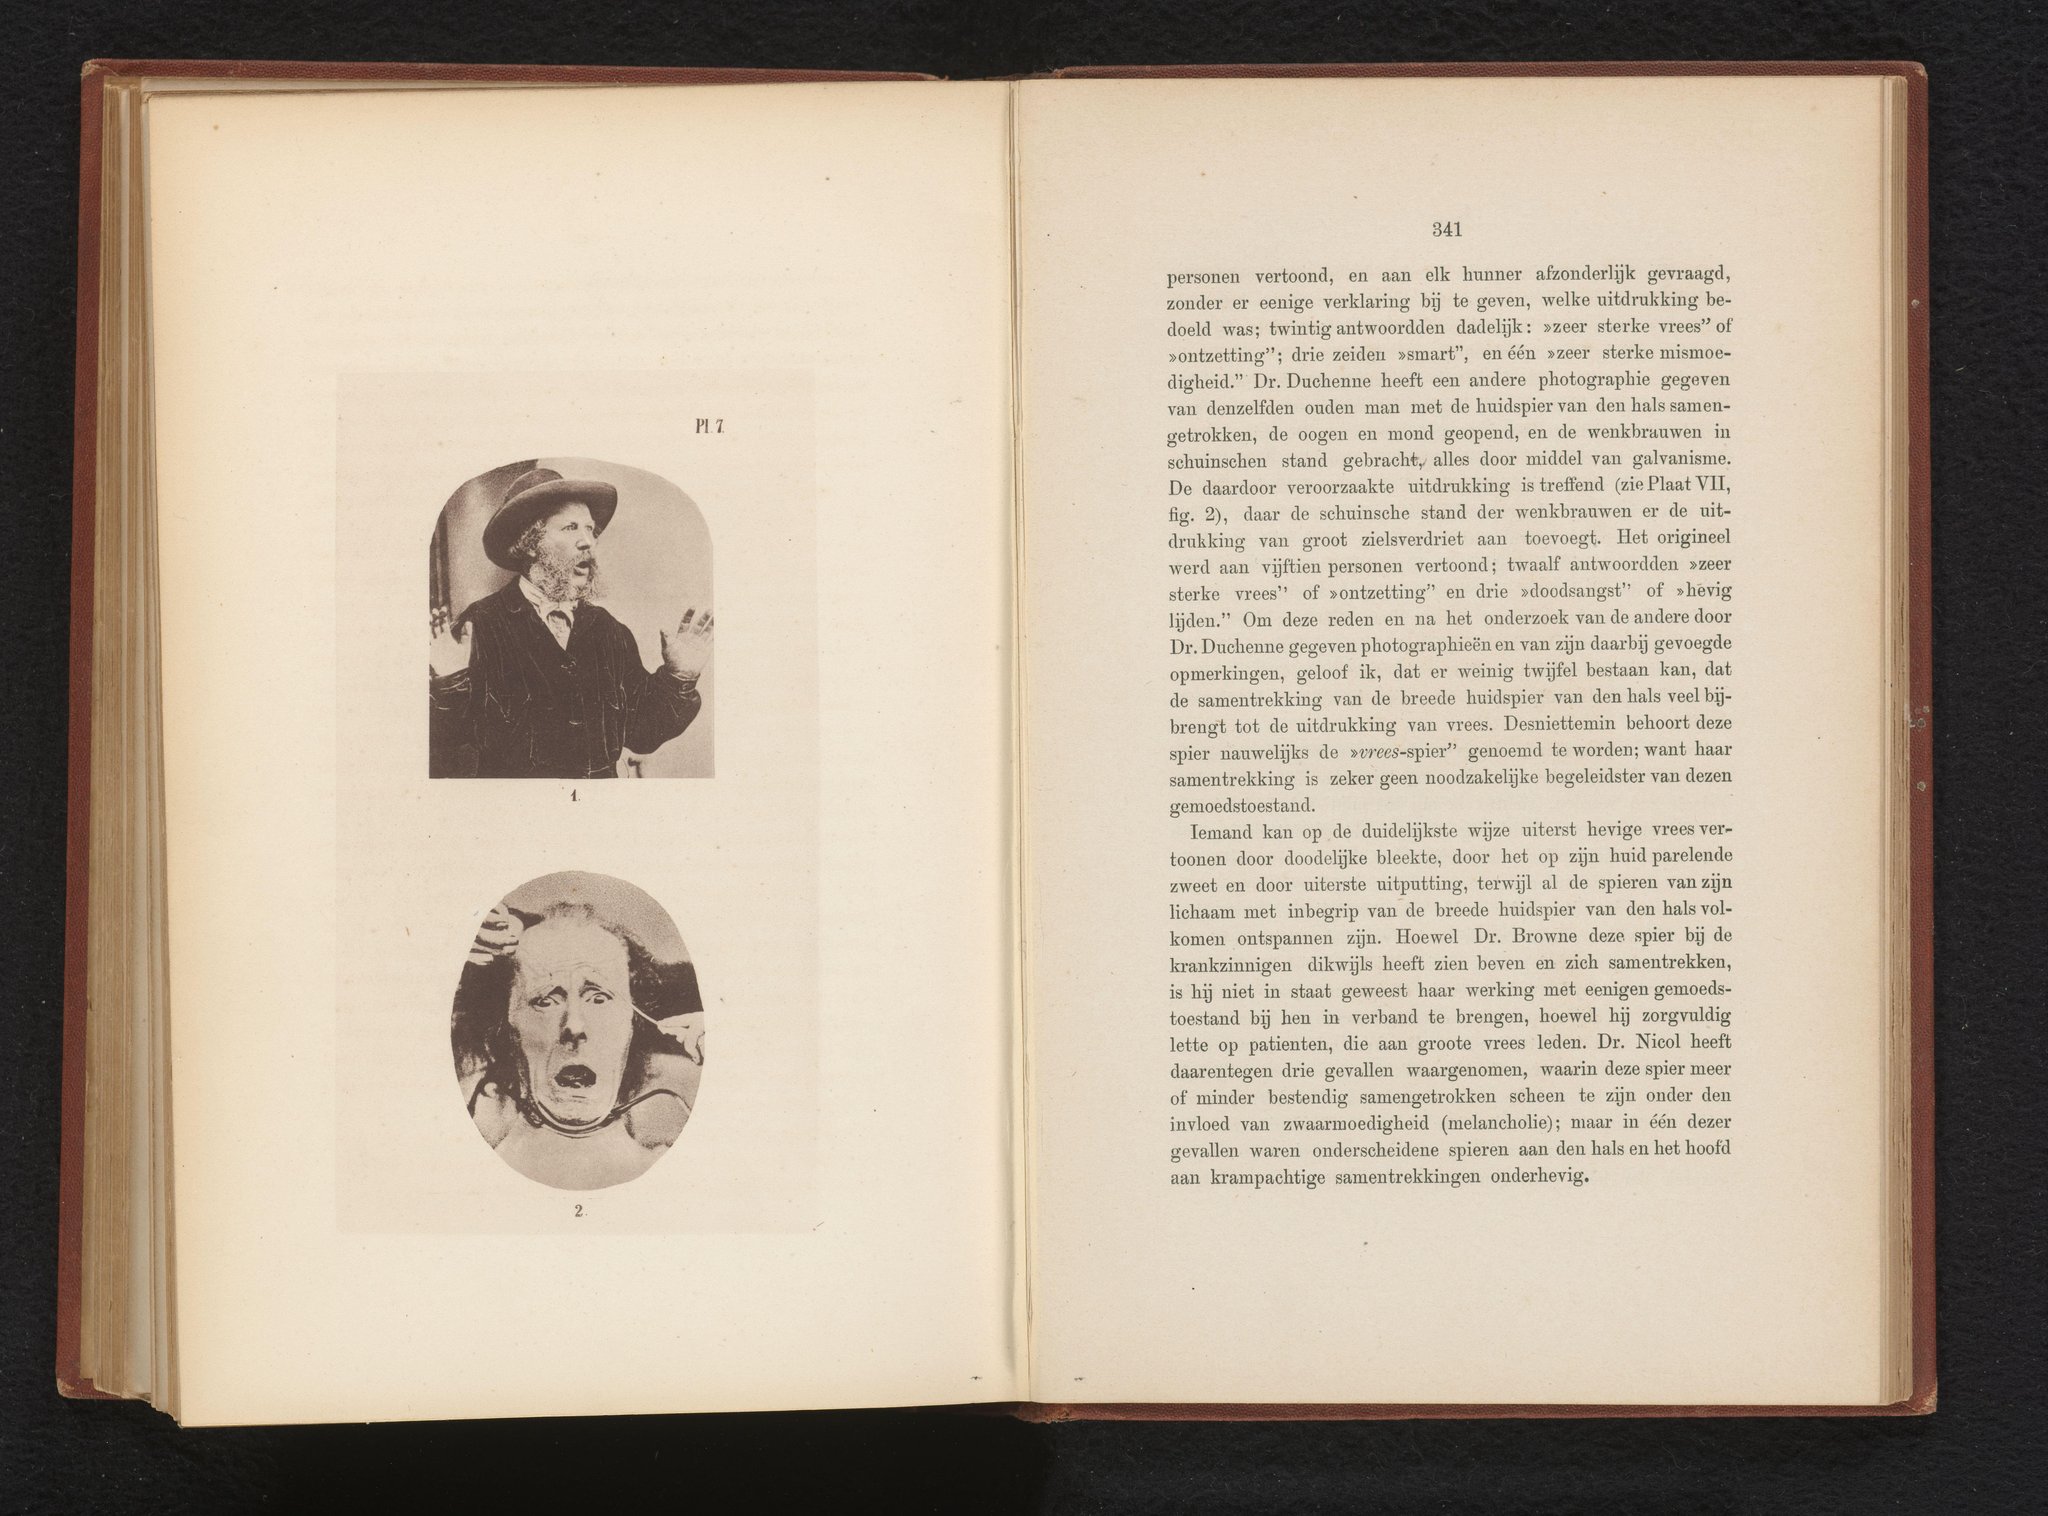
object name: photomechanical print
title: Twee foto's van mannen die angst tonen, boven een zelfportret van Oscar Gustave Rejlander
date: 1868-1873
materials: paper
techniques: photograph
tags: oscar gustave rejlander, historical persons, morphology of facial expression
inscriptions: inscription: ‘Pl. 7.’